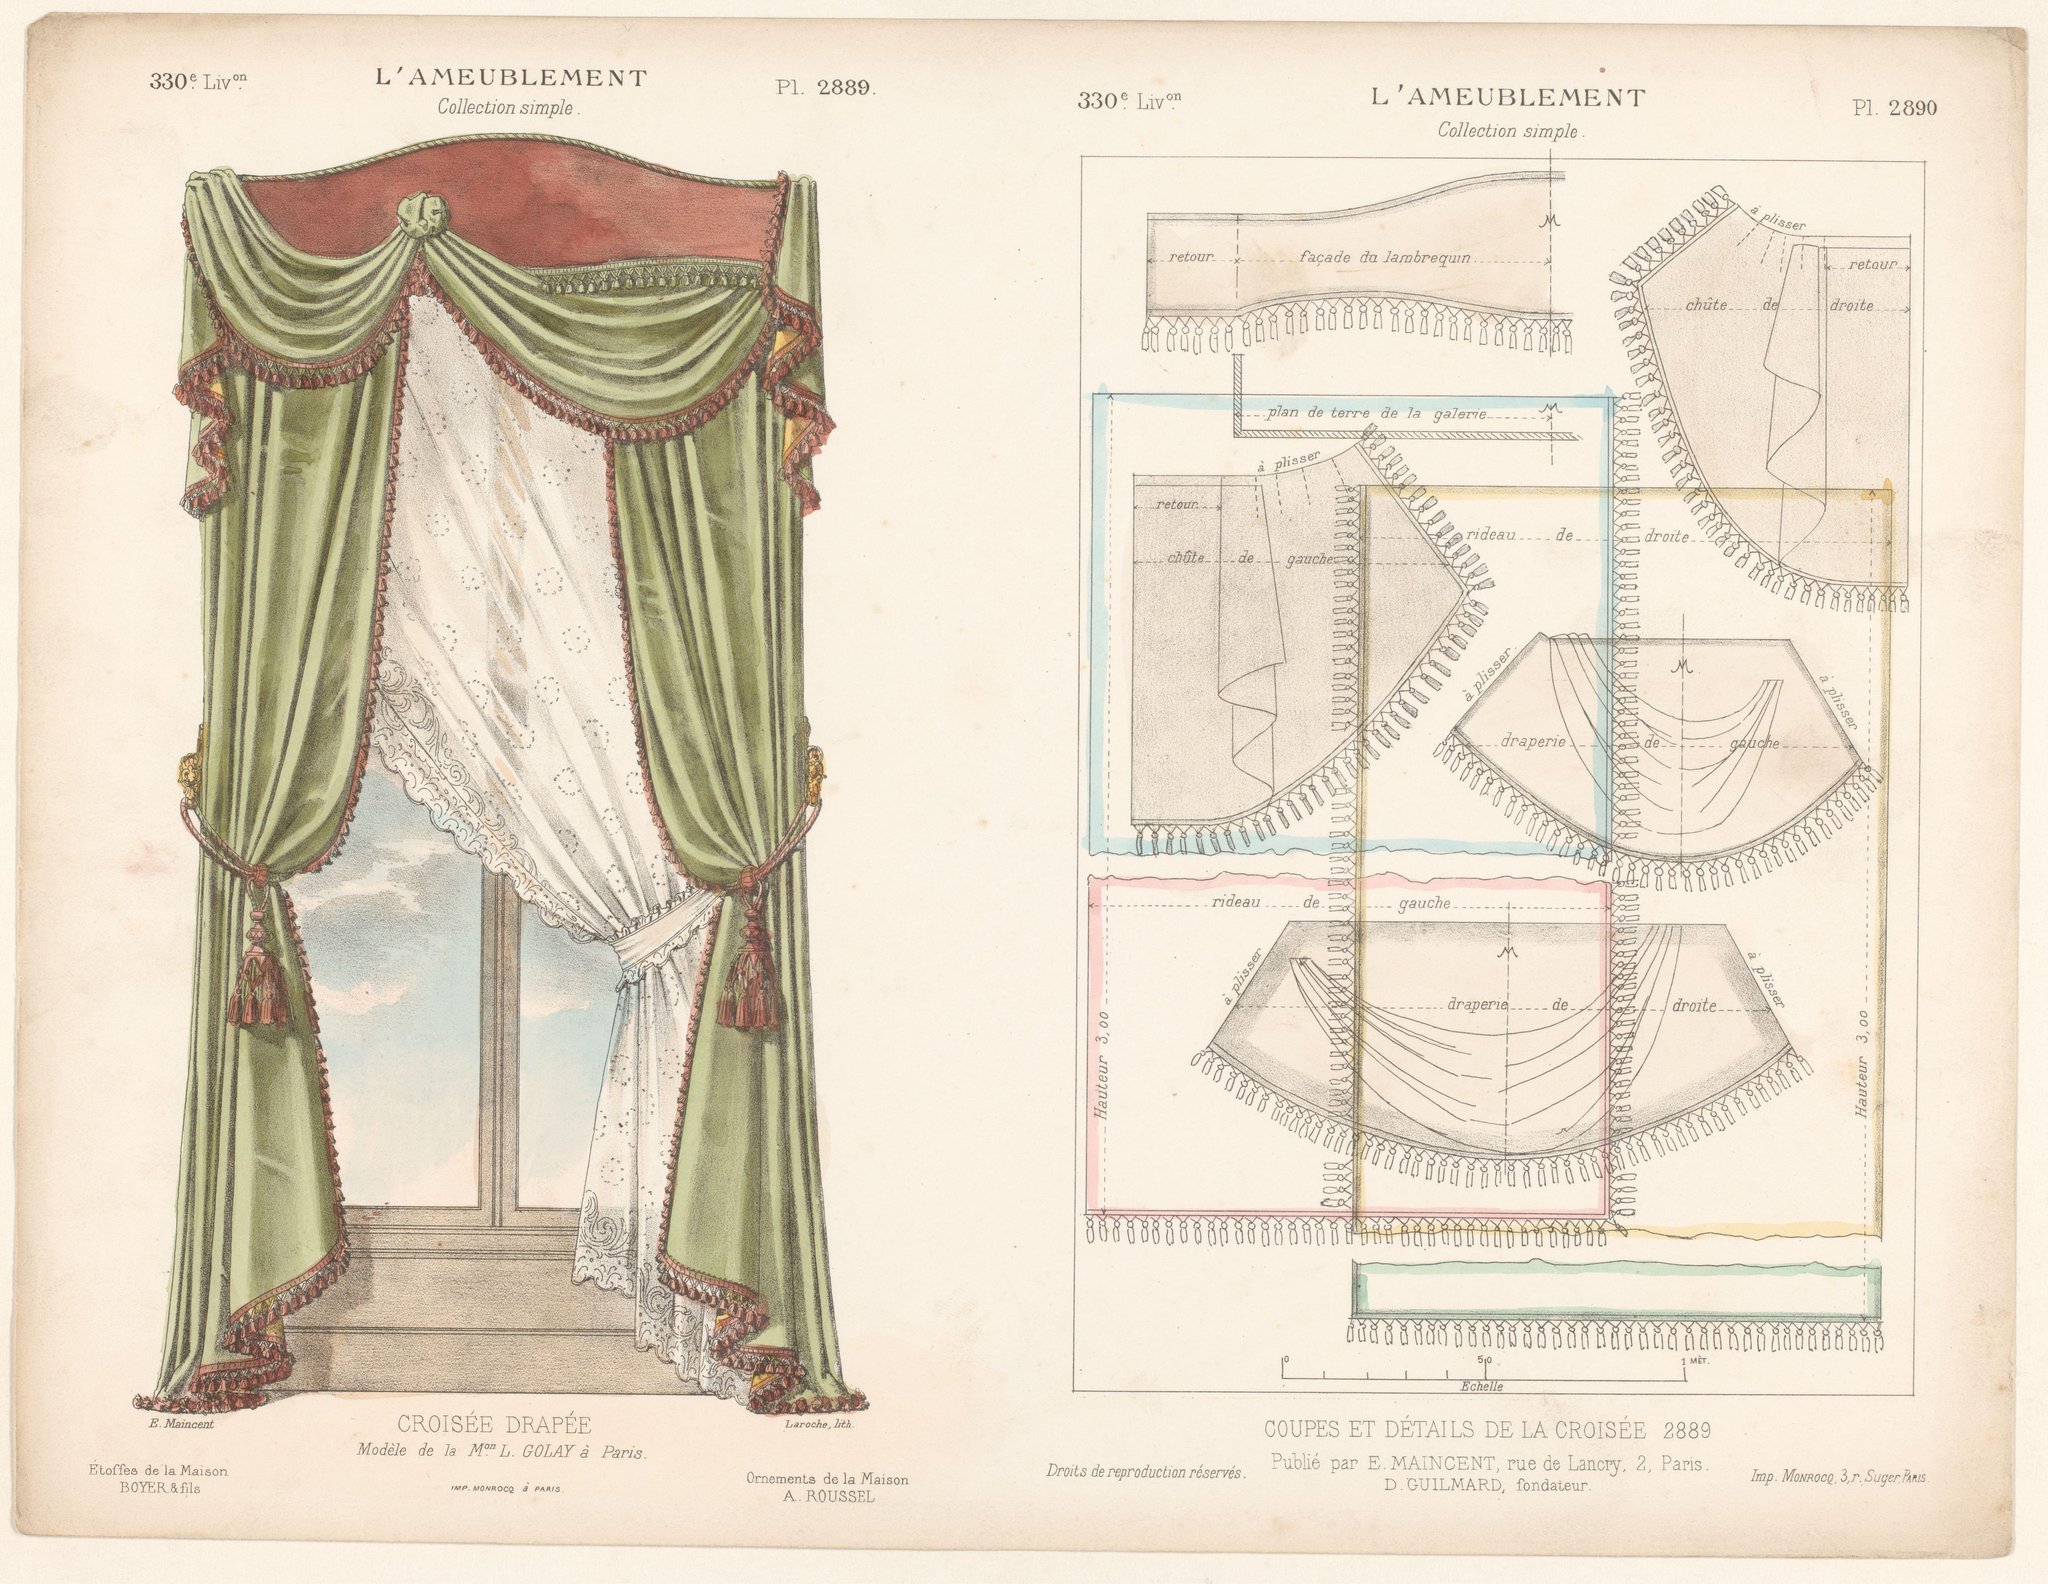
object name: print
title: Venster met gordijnen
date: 1885-1895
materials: paper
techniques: hand coloring, lithograph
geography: paris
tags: window, hangings and drapery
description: Een venster met gedrapeerde gordijnen. Rechts details van de draperieën. Prent uit 330e Livraison.